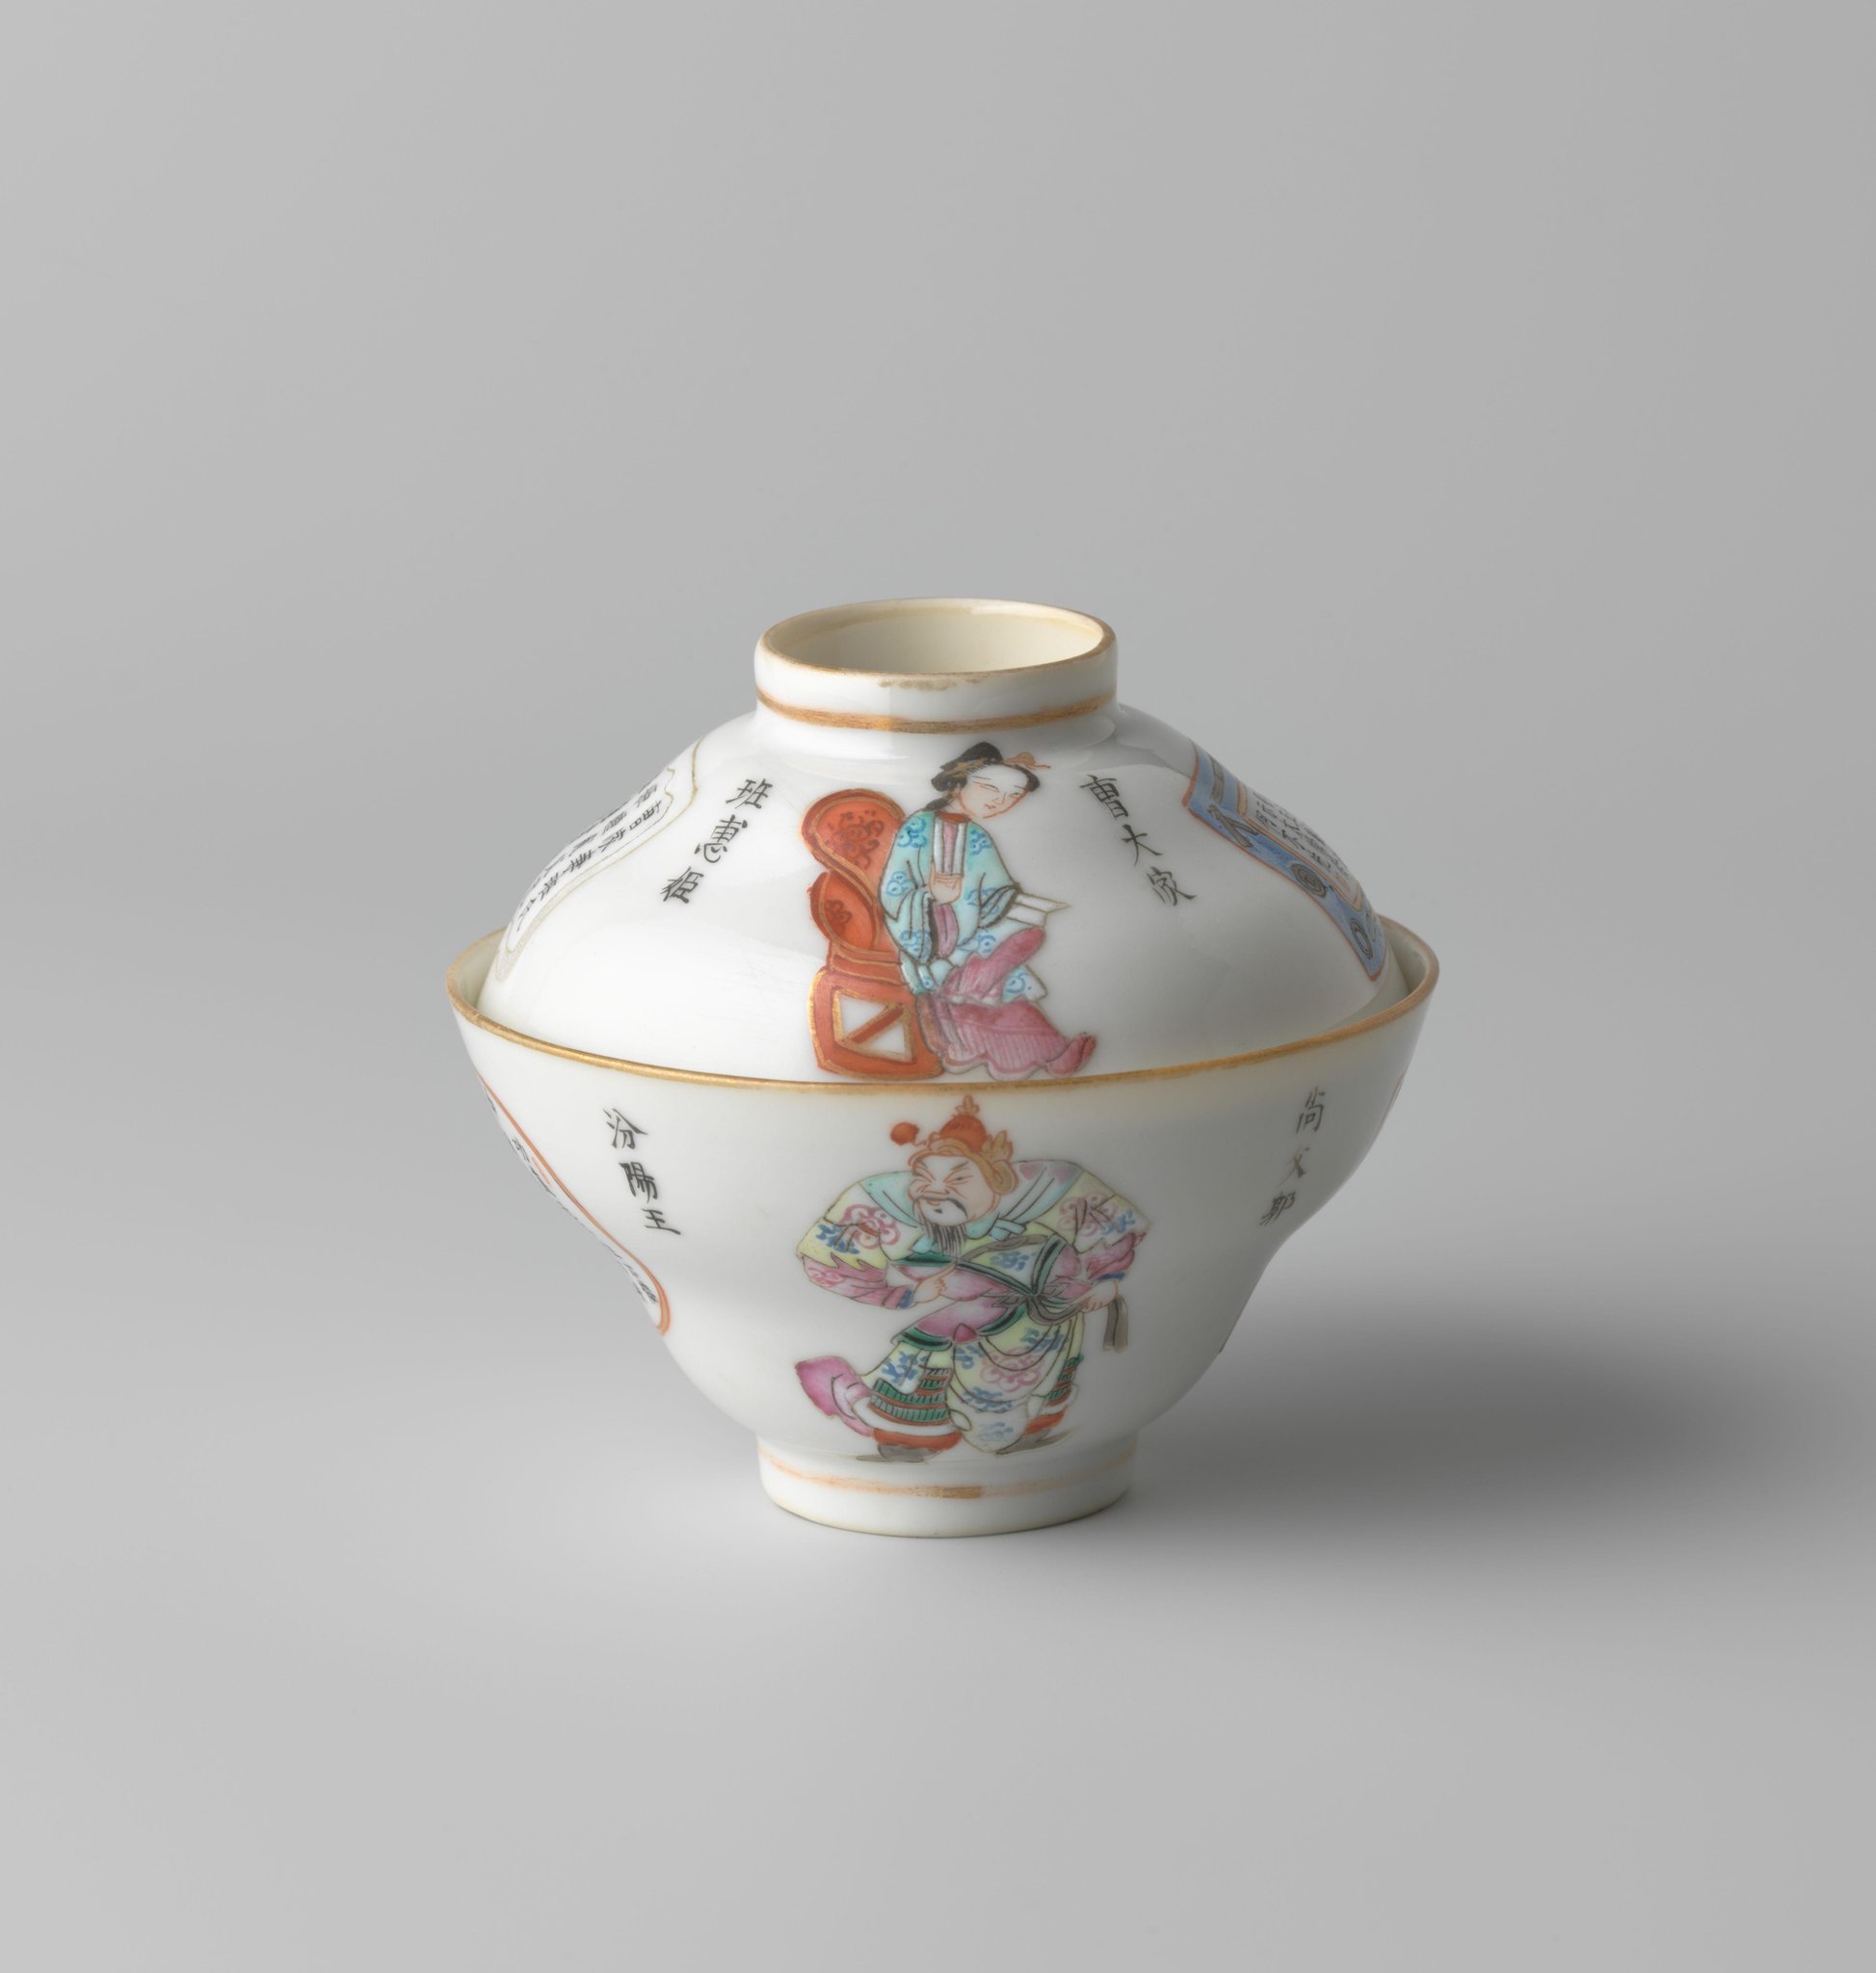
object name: cup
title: Covered cup with figures, a go-bord and inscriptions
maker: Anonymous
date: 1800-1899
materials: glaze, gold, paint, porcelain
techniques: firing, gilding, turning, vitrification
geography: china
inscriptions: mark: ‘大 清 咸 豐 年 製’, mark: ‘大 清 道 光 年 製’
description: Dekselkop van porselein met een getrapte wand, beschilderd op het glazuur in blauw, rood, roze, groen, geel, zwart en goud. De kop met dezelfde soort decoratie als de schotel, met andere cartouches en personen. De kop gemerkt met het zegelmerk van keizer Daoguang (?). Famille rose.